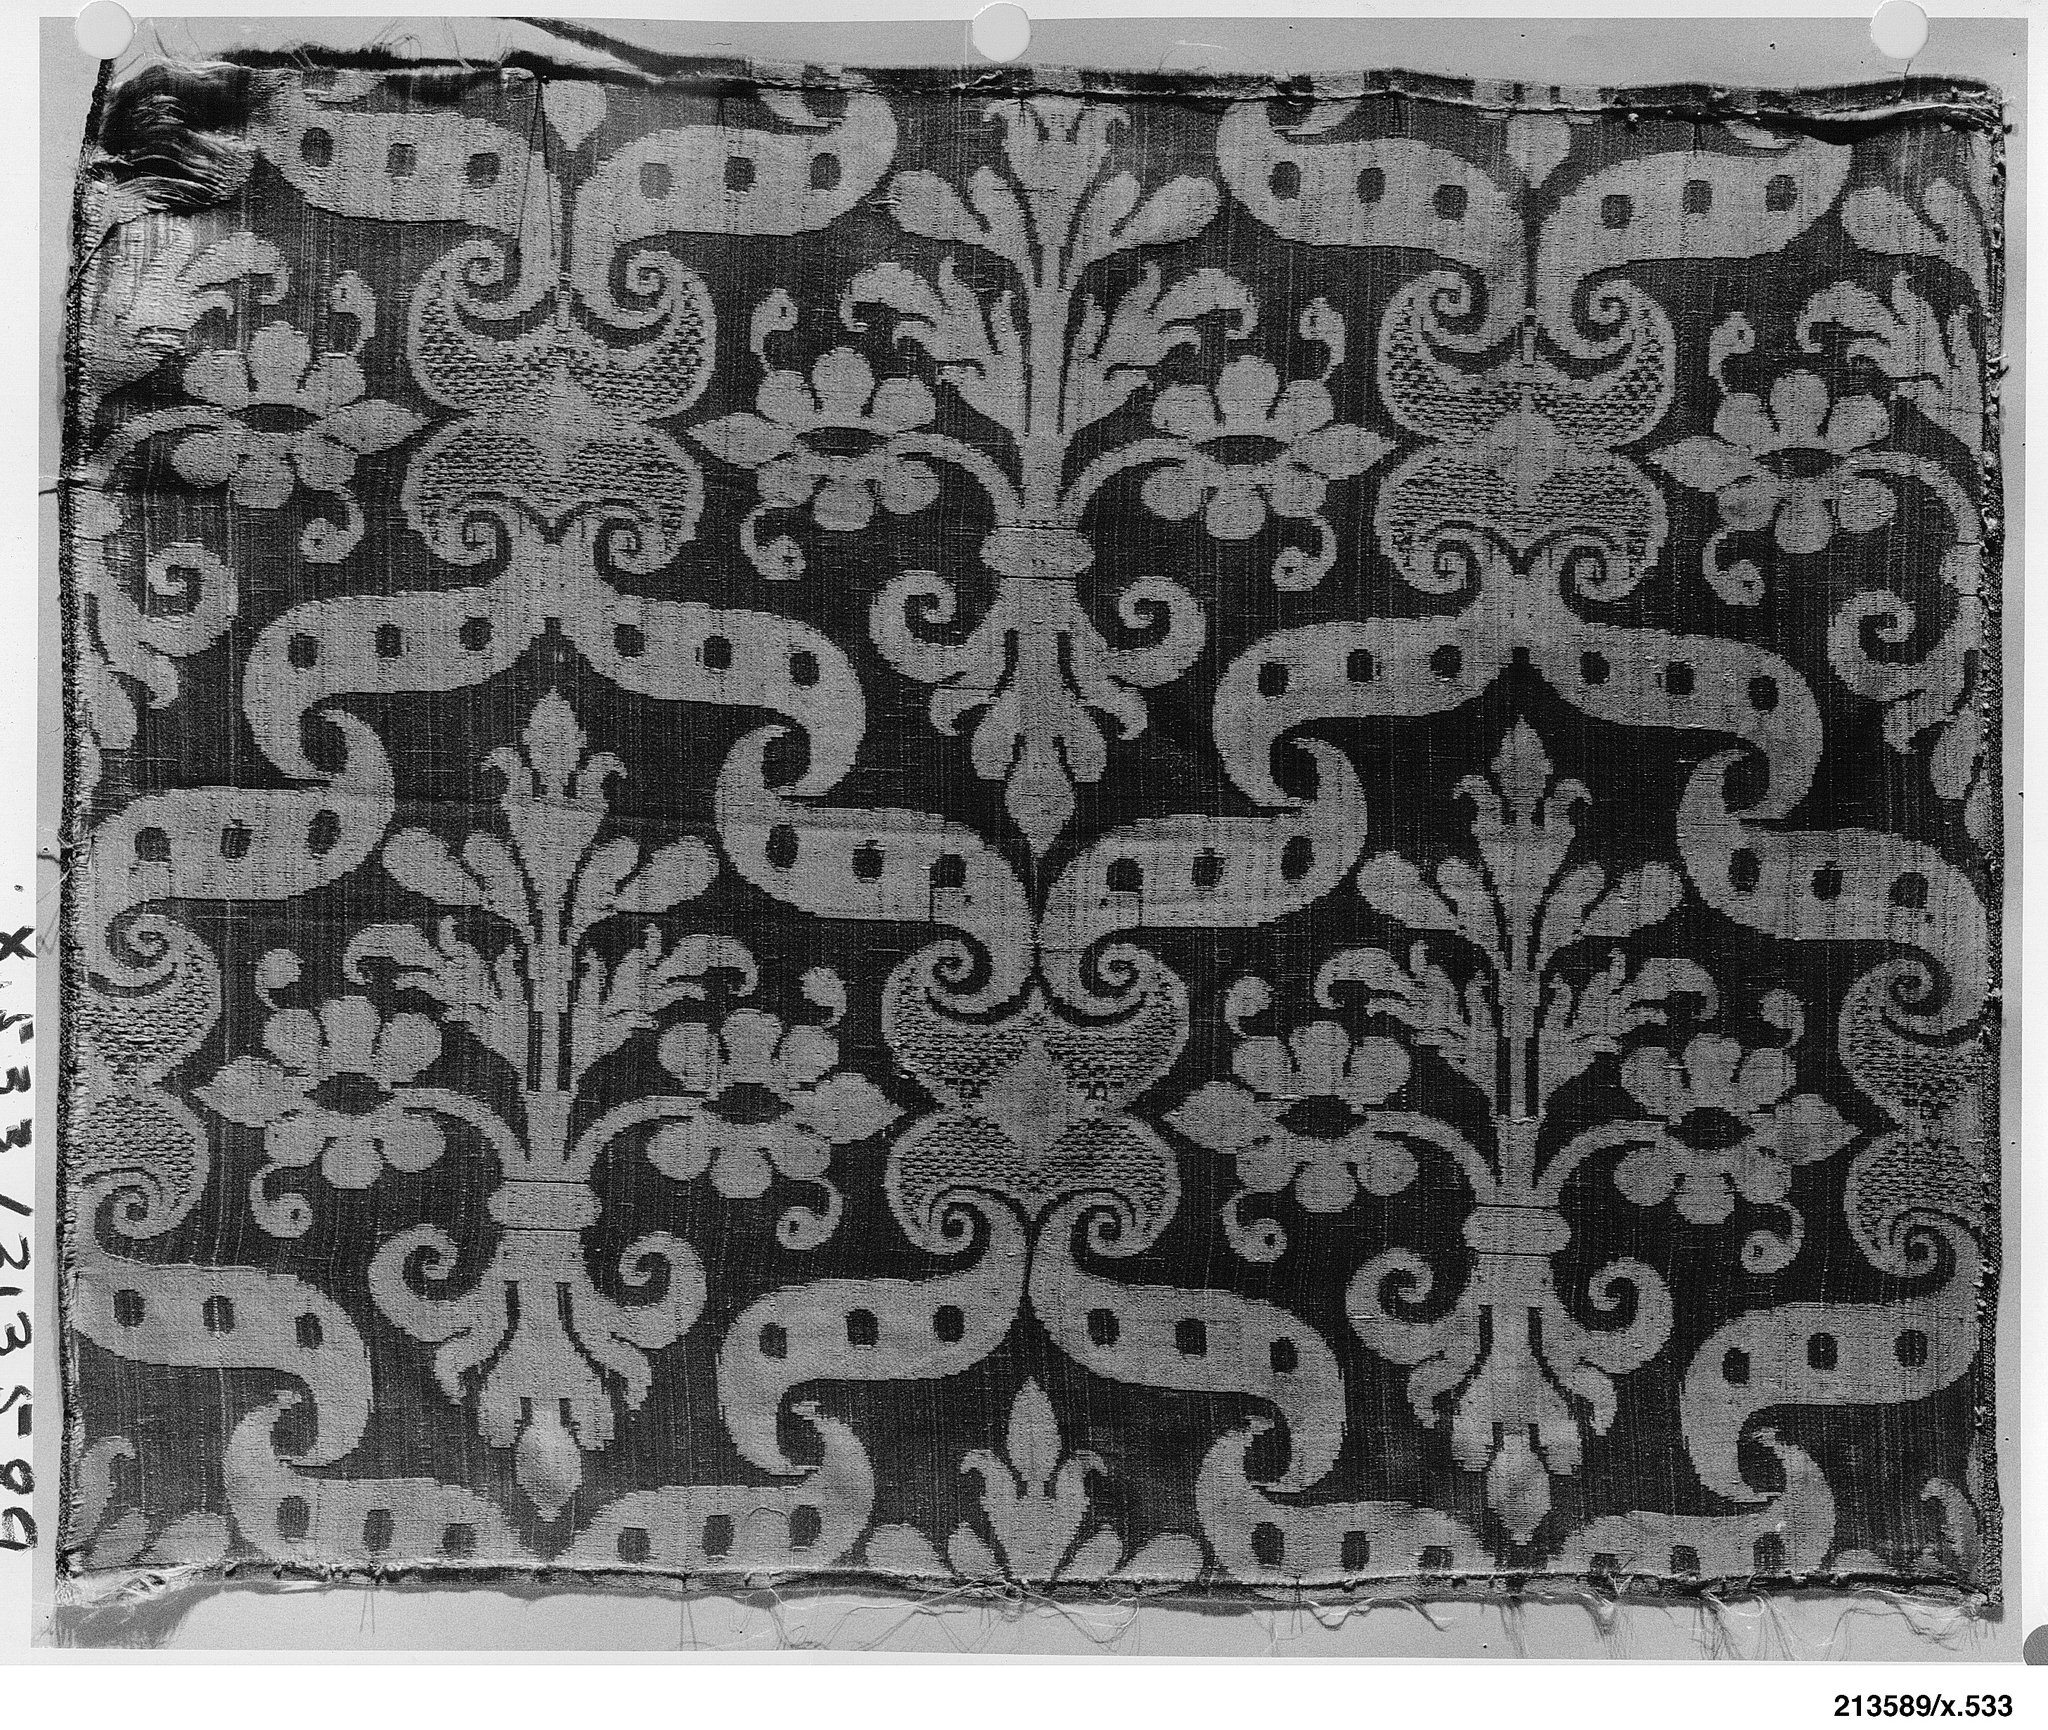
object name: piece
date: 1501-1600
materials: silk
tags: leaves